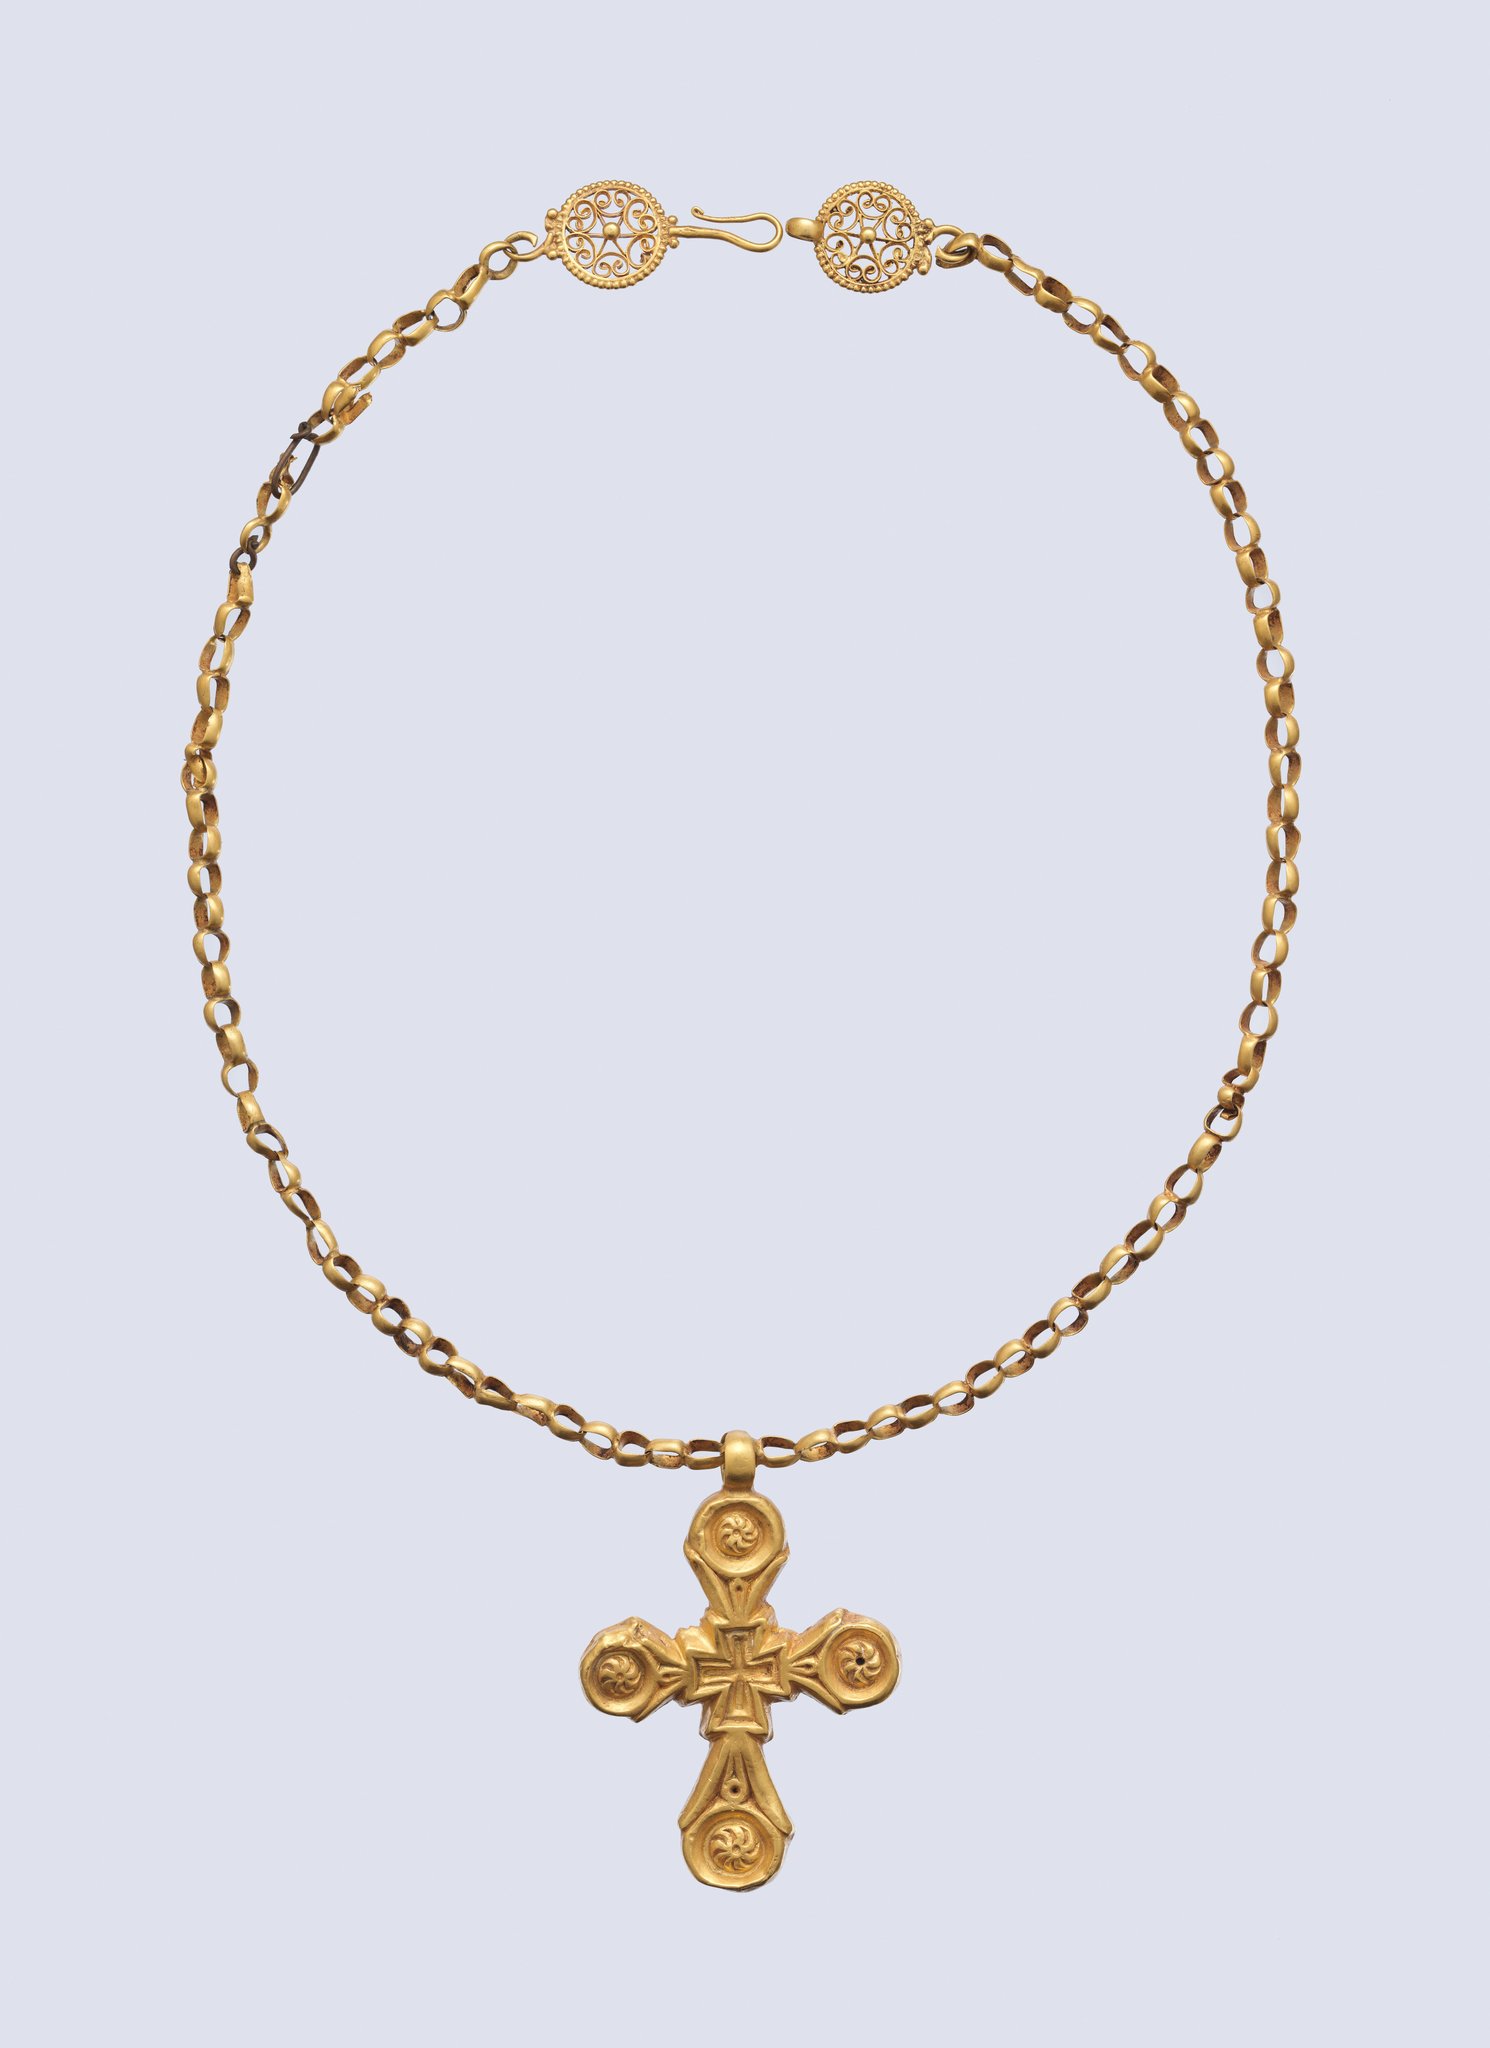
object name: necklace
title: Necklace with Pendant Cross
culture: byzantine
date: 501-600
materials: gold